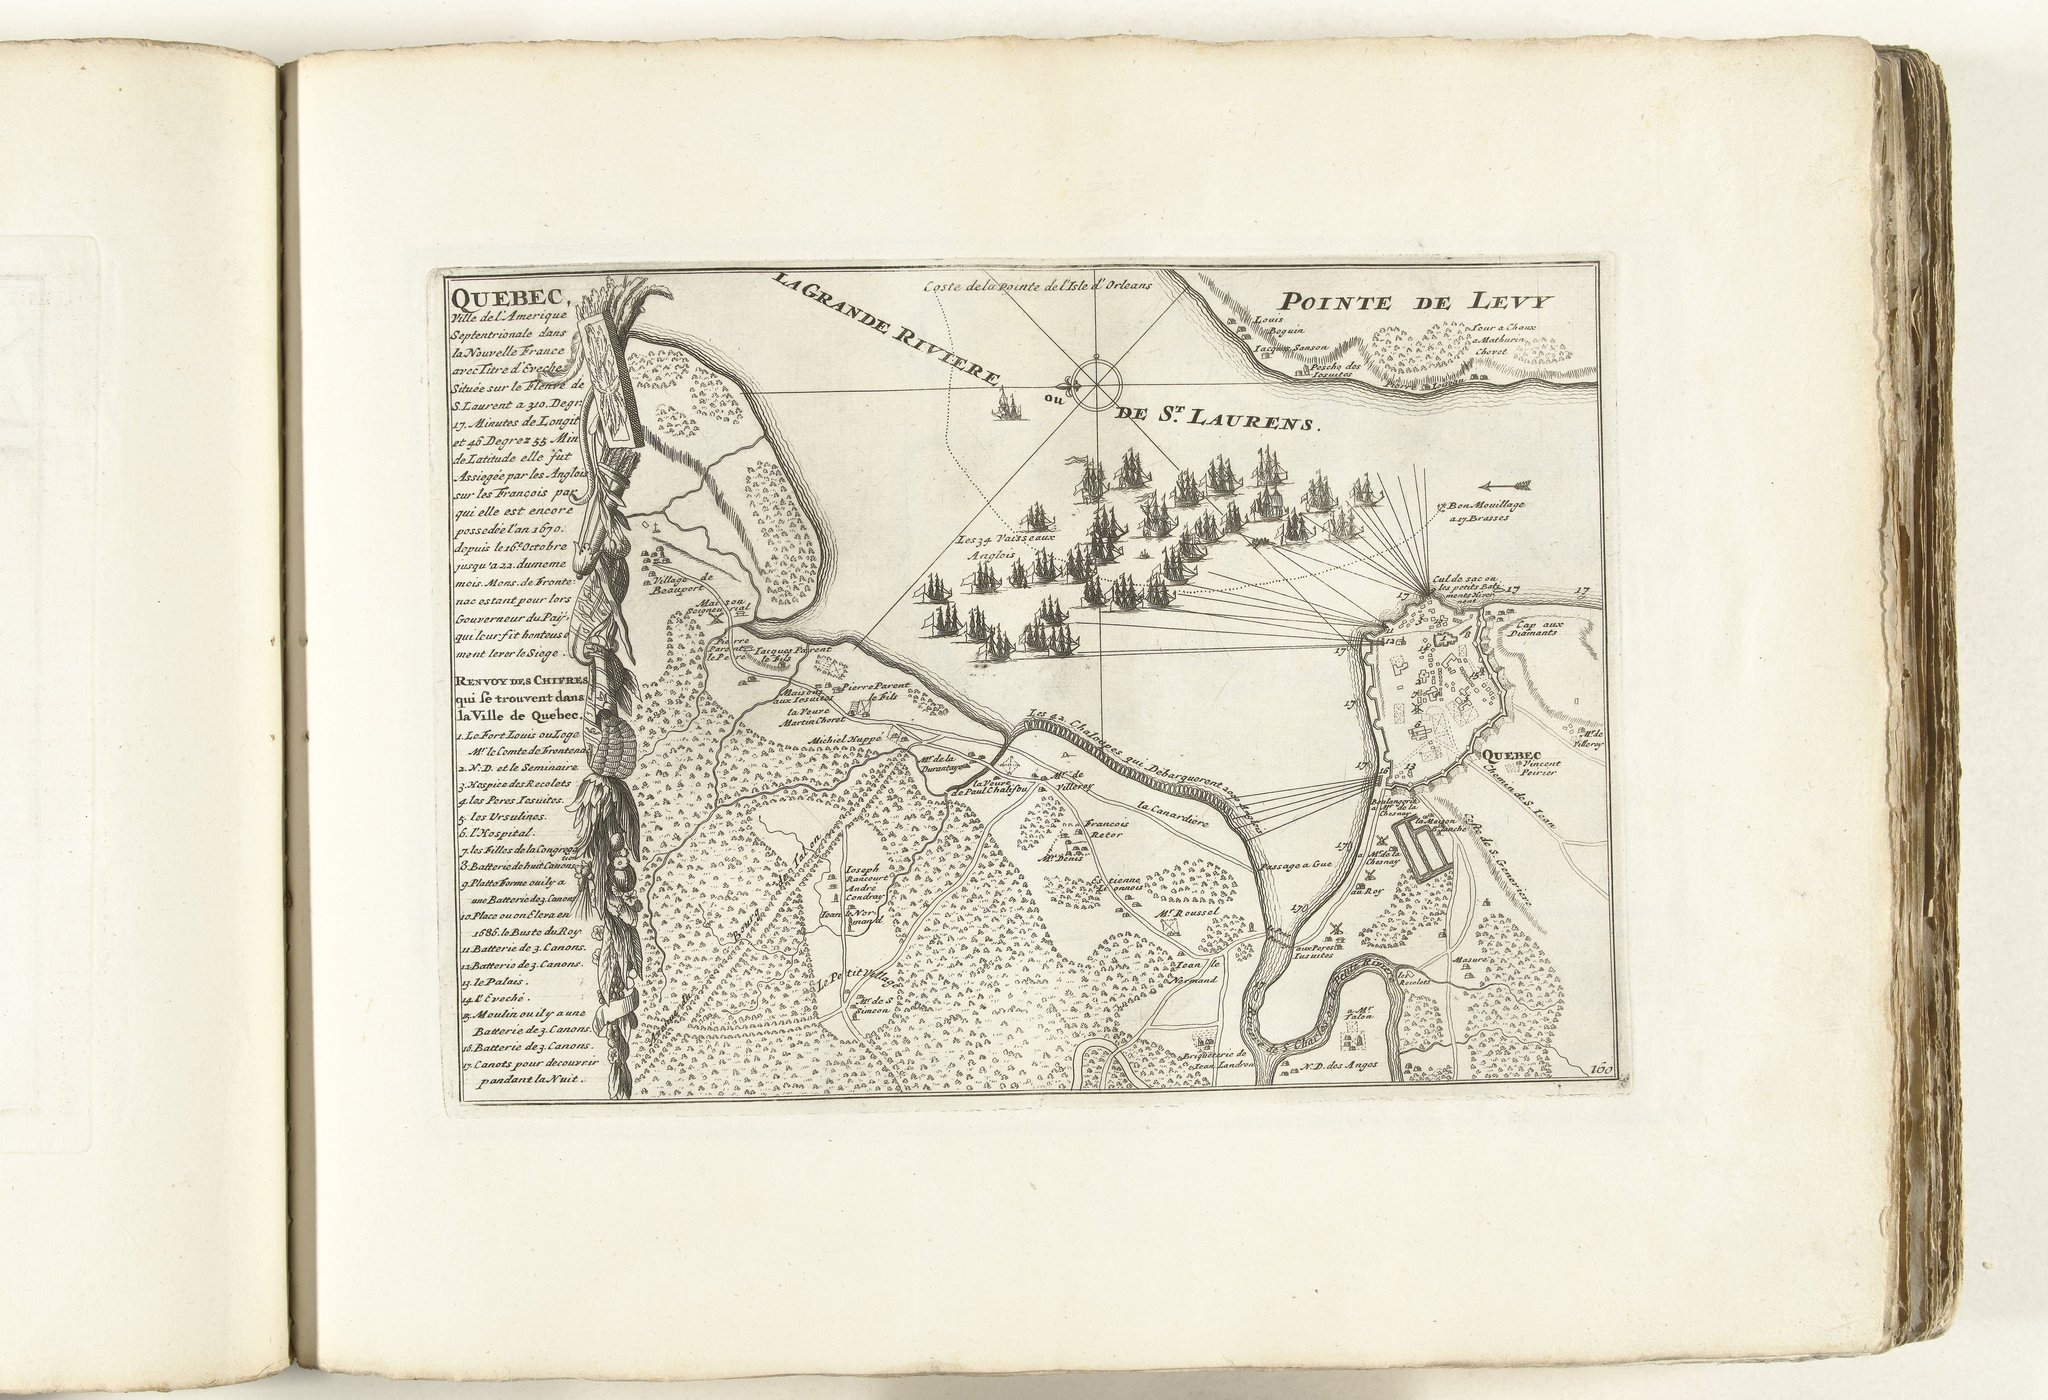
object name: print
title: Quebec, Ville de l'Amerique Septentrionale, dans la Nouvelle France (...)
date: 1702-1703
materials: paper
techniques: etching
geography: amsterdam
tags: maps of separate countries or regions, battle (+ land forces), québec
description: Aanval door Engelse schepen op de Fransen in de stad Québec, de aanval wordt afgeslagen, 16-22 oktober 1690. Kaart van Québc en omgeving met de Engelse vloot op de Saint Lawrencerivier voor de stad. Plaat nr. 160 in het prentwerk bestaande in totaal uit 276 genummerde platen van vermaarde sterke steden en vestingen in het kader van de Spaanse Successieoorlog. Voor het merendeel zijn deze platen gekopieerd naar de anonieme Franse platen: in Les forces de l'Europe en in: Le theatre de la guerre, dans les Pays-Bas, beide oorspronkelijk uitgegeven door Nicolas de Fer te Parijs (1693-1697) in het kader van de Negenjarige Oorlog. Titel en opschriften in de plaat in het Frans.